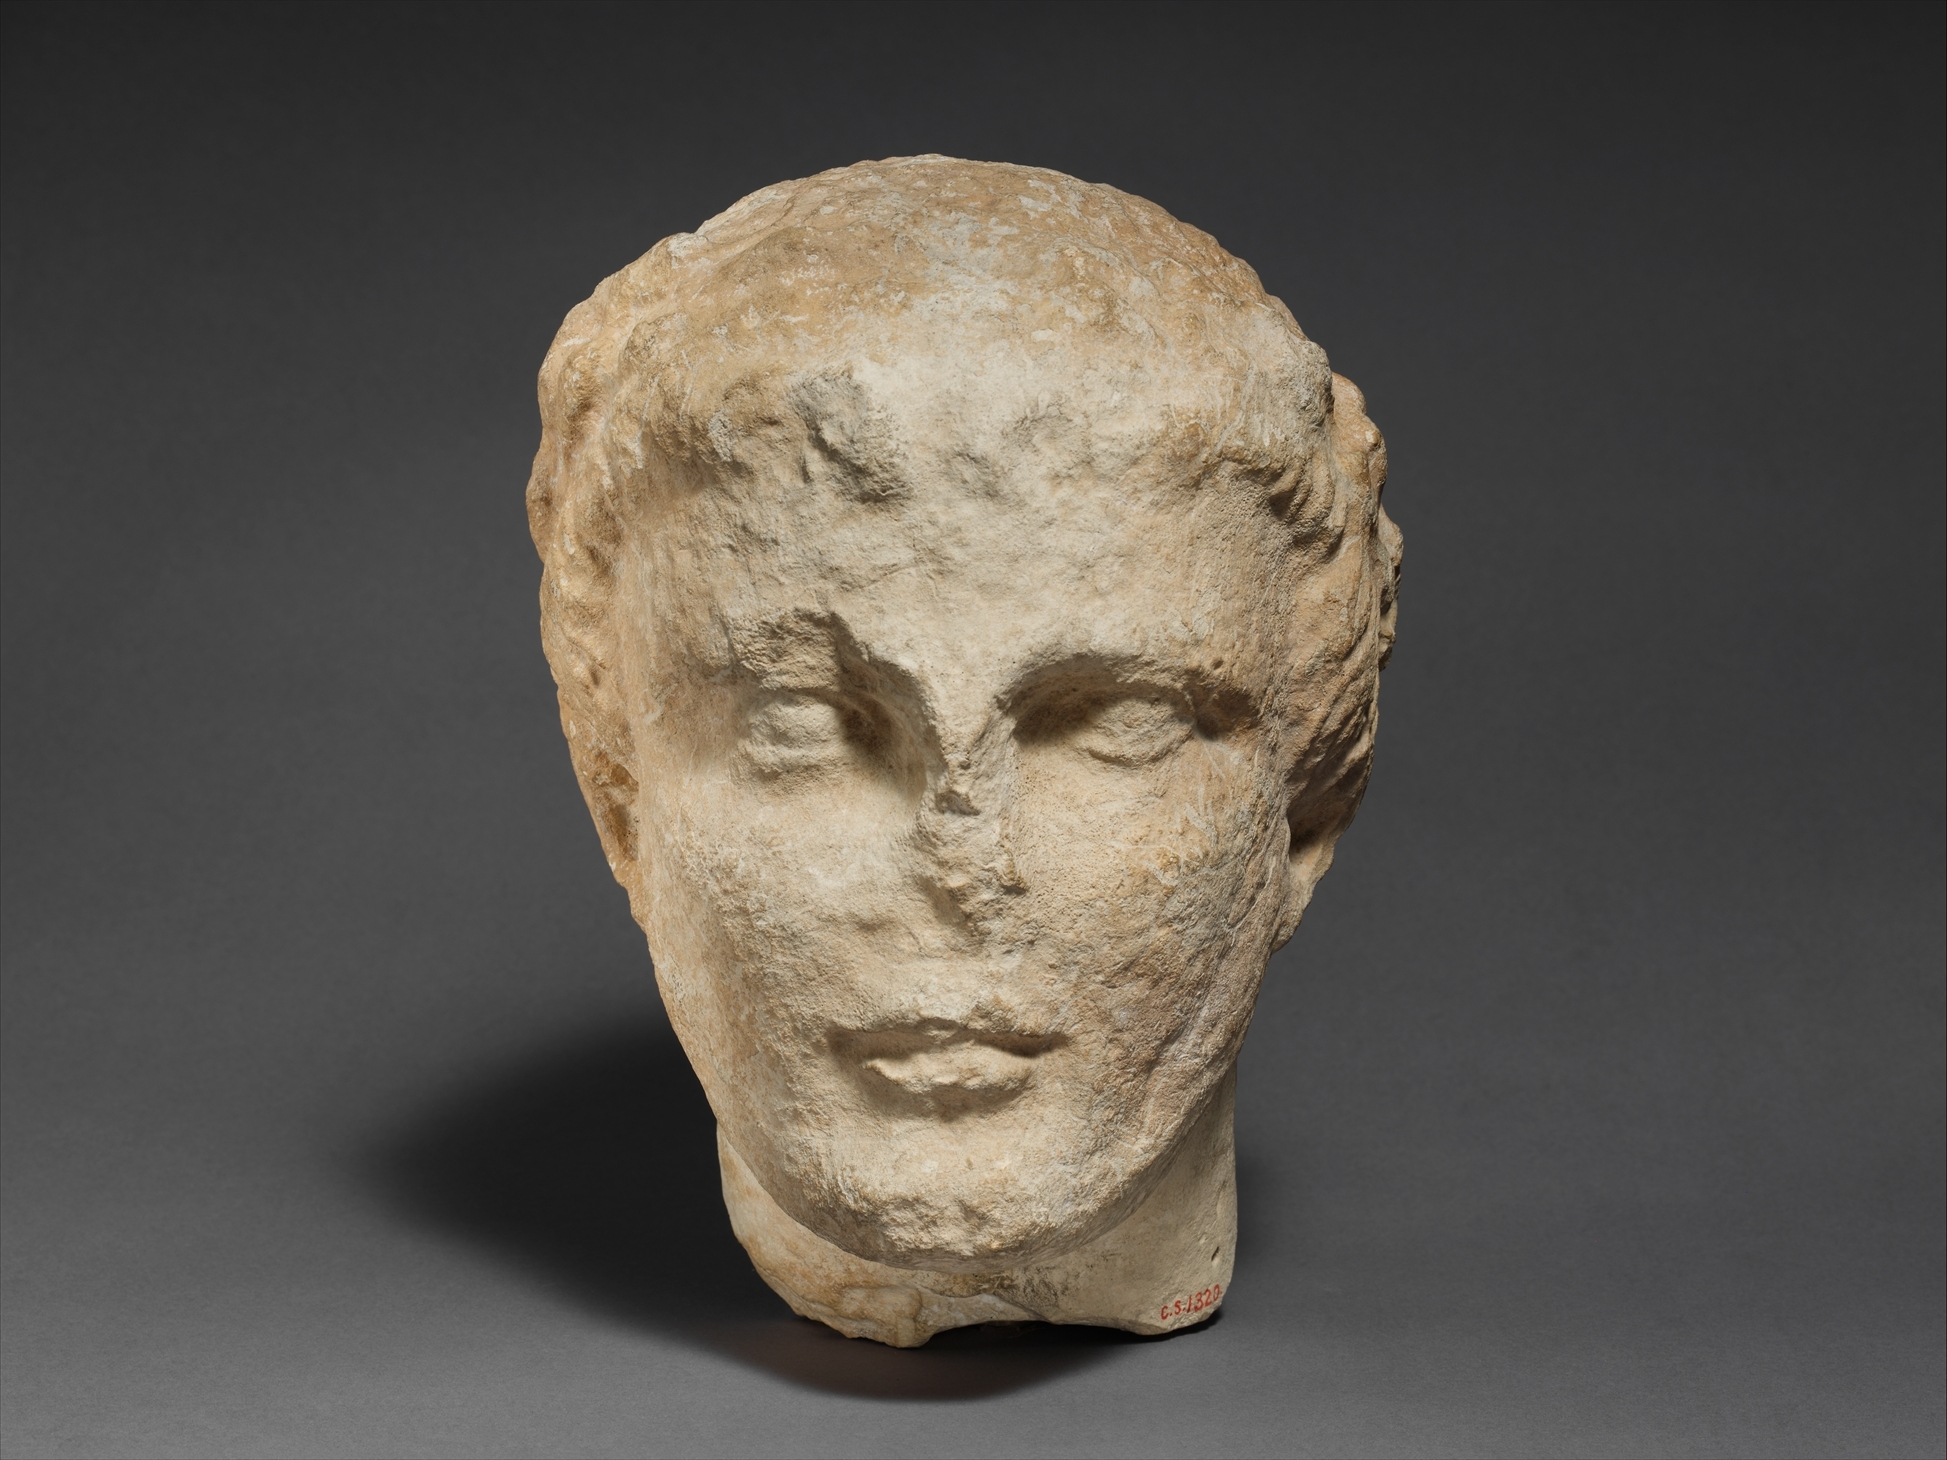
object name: head of a male votary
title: Limestone head of a bearded male votary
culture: cypriot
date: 400-201 BCE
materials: limestone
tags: heads,men